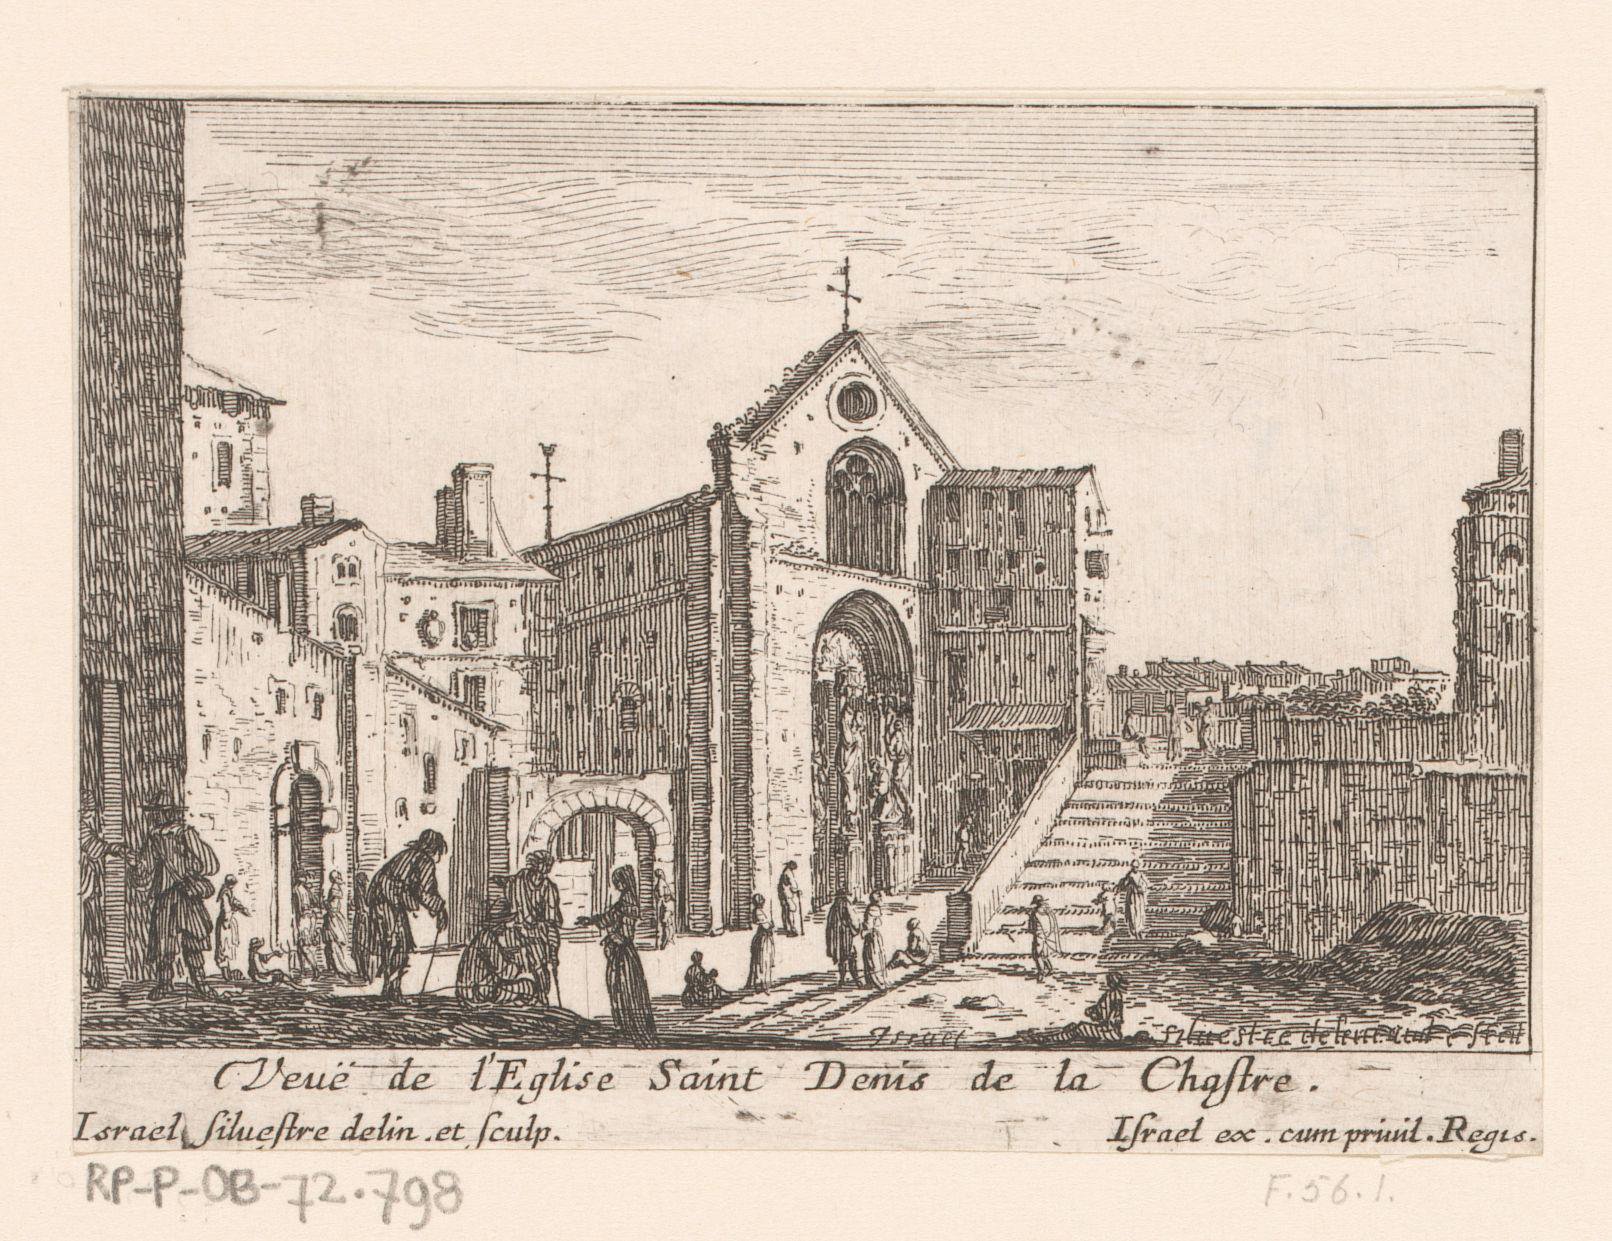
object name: print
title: Gezichten op Parijs en omgeving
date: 1631-1661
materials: paper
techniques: etching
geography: france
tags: church (exterior), city-view, and landscape with man-made constructions (+ city(-scape) with figures, staffage), paris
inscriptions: collector's mark: Lugt 240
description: Prent maakt deel uit van een ongenummerde serie van dertien prenten.